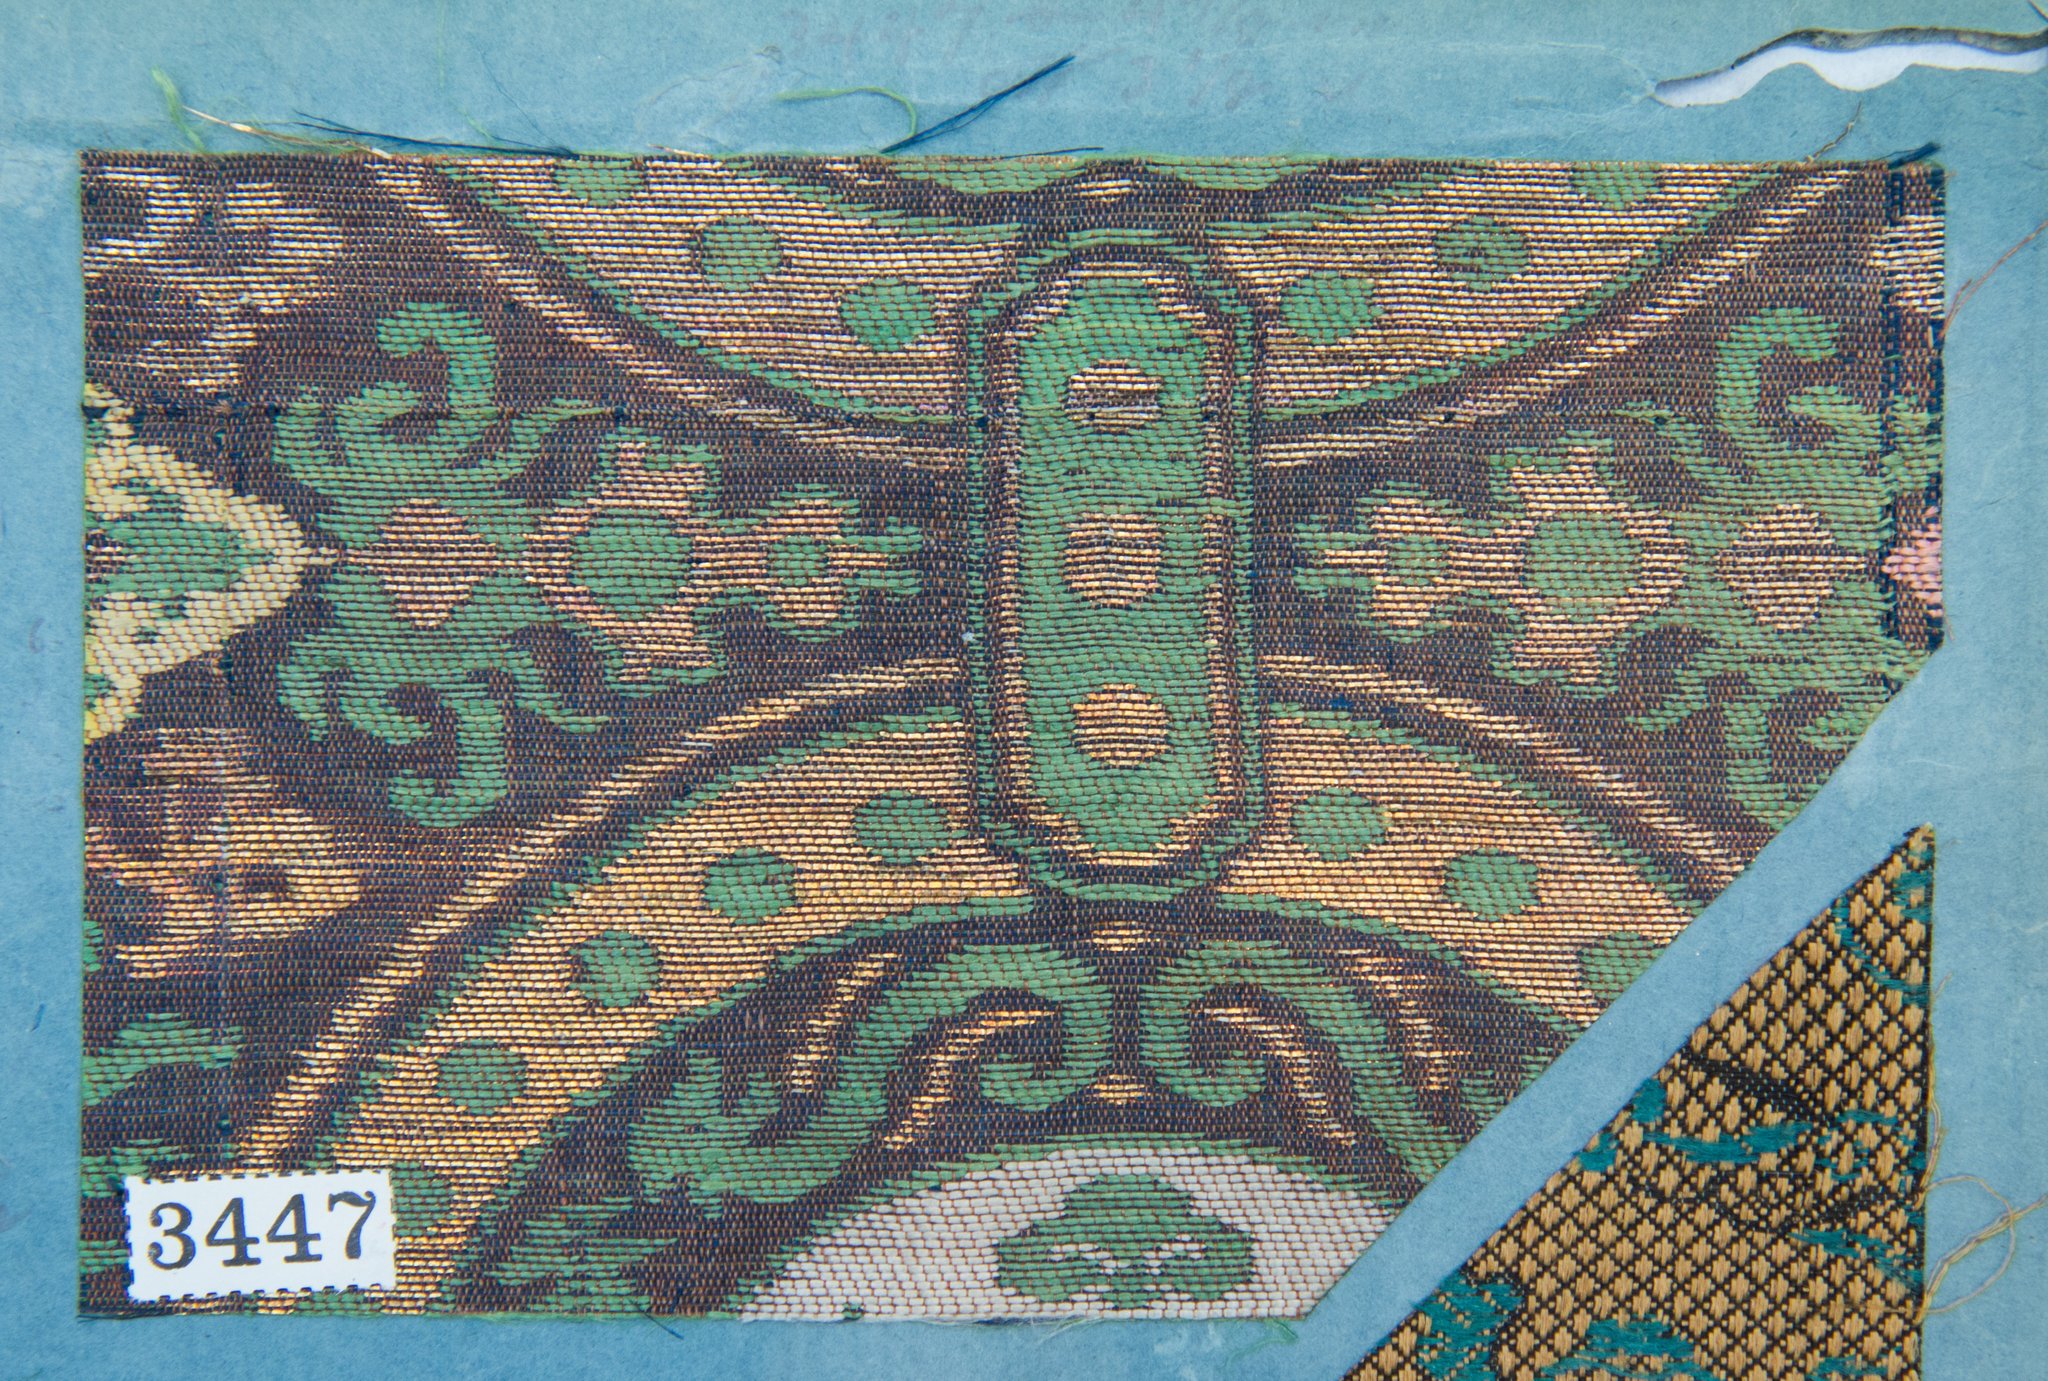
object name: sample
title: Textile Sample from Sample Book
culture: japanese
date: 1801-1900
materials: silk